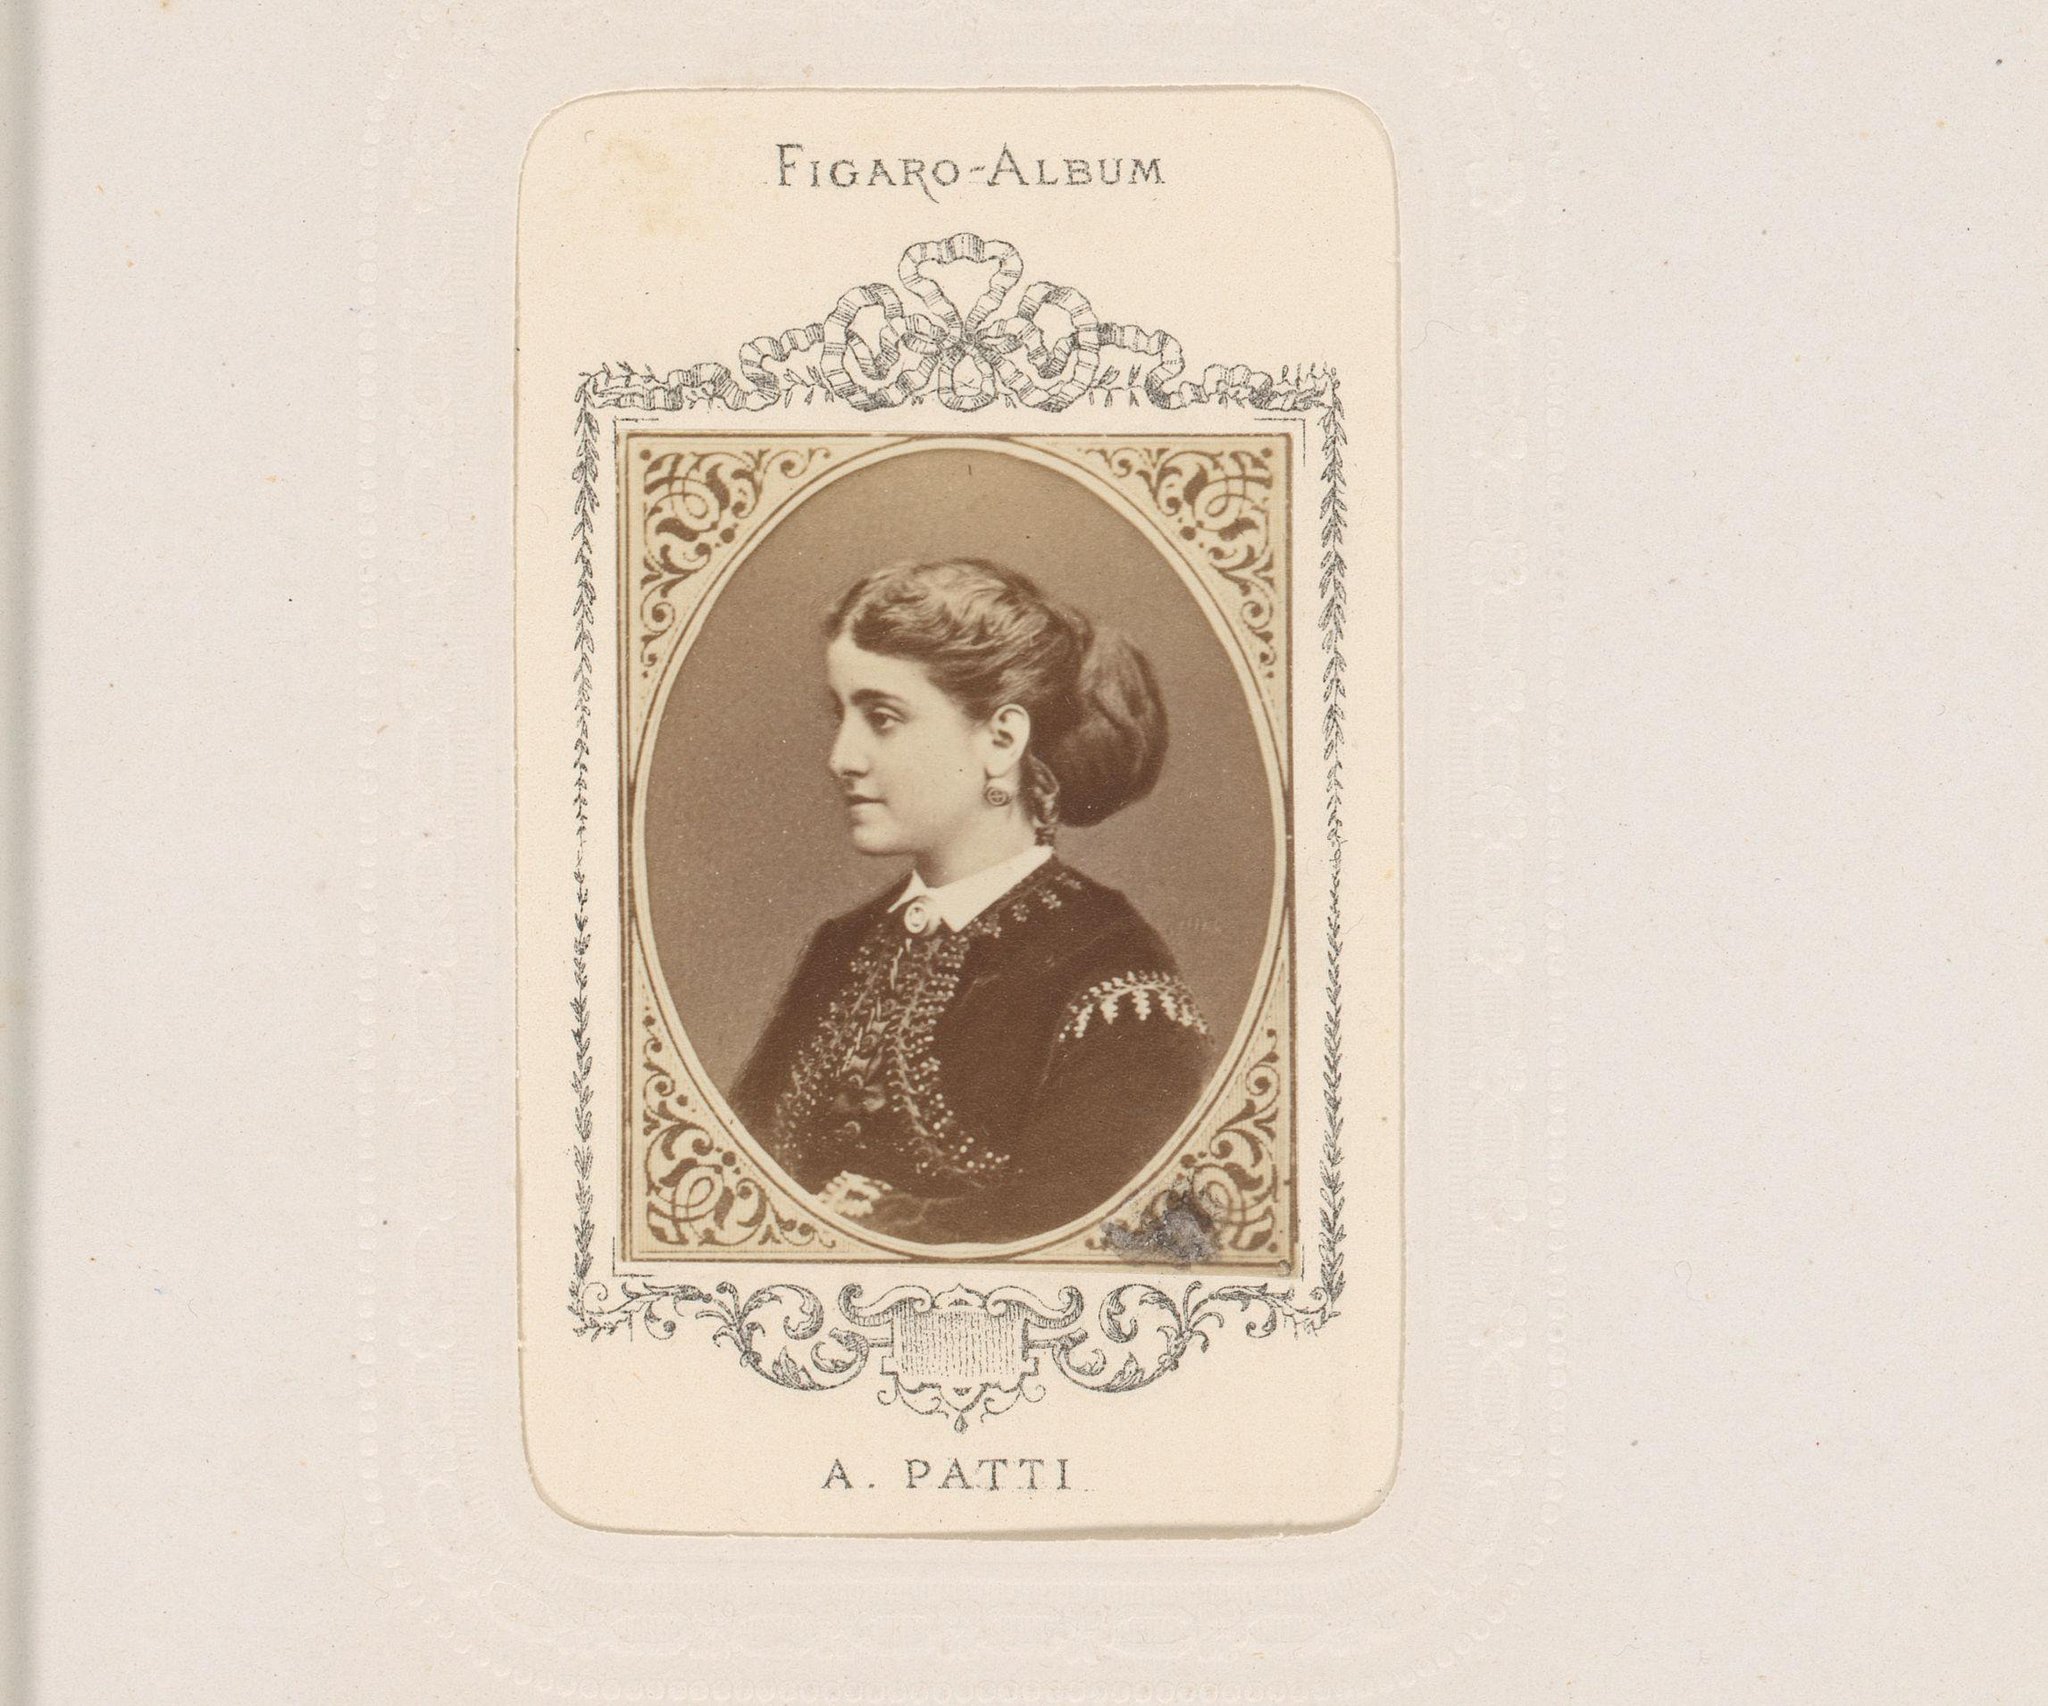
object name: reproduction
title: Fotoreproductie van een portret van Adelina Patti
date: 1860-1900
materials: cardboard, photographic support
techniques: albumen print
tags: historical persons - bb - woman, opera-singer (female)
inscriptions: inscription: ‘Figaro-Album/ A. Patti/ Liébert Phot.’